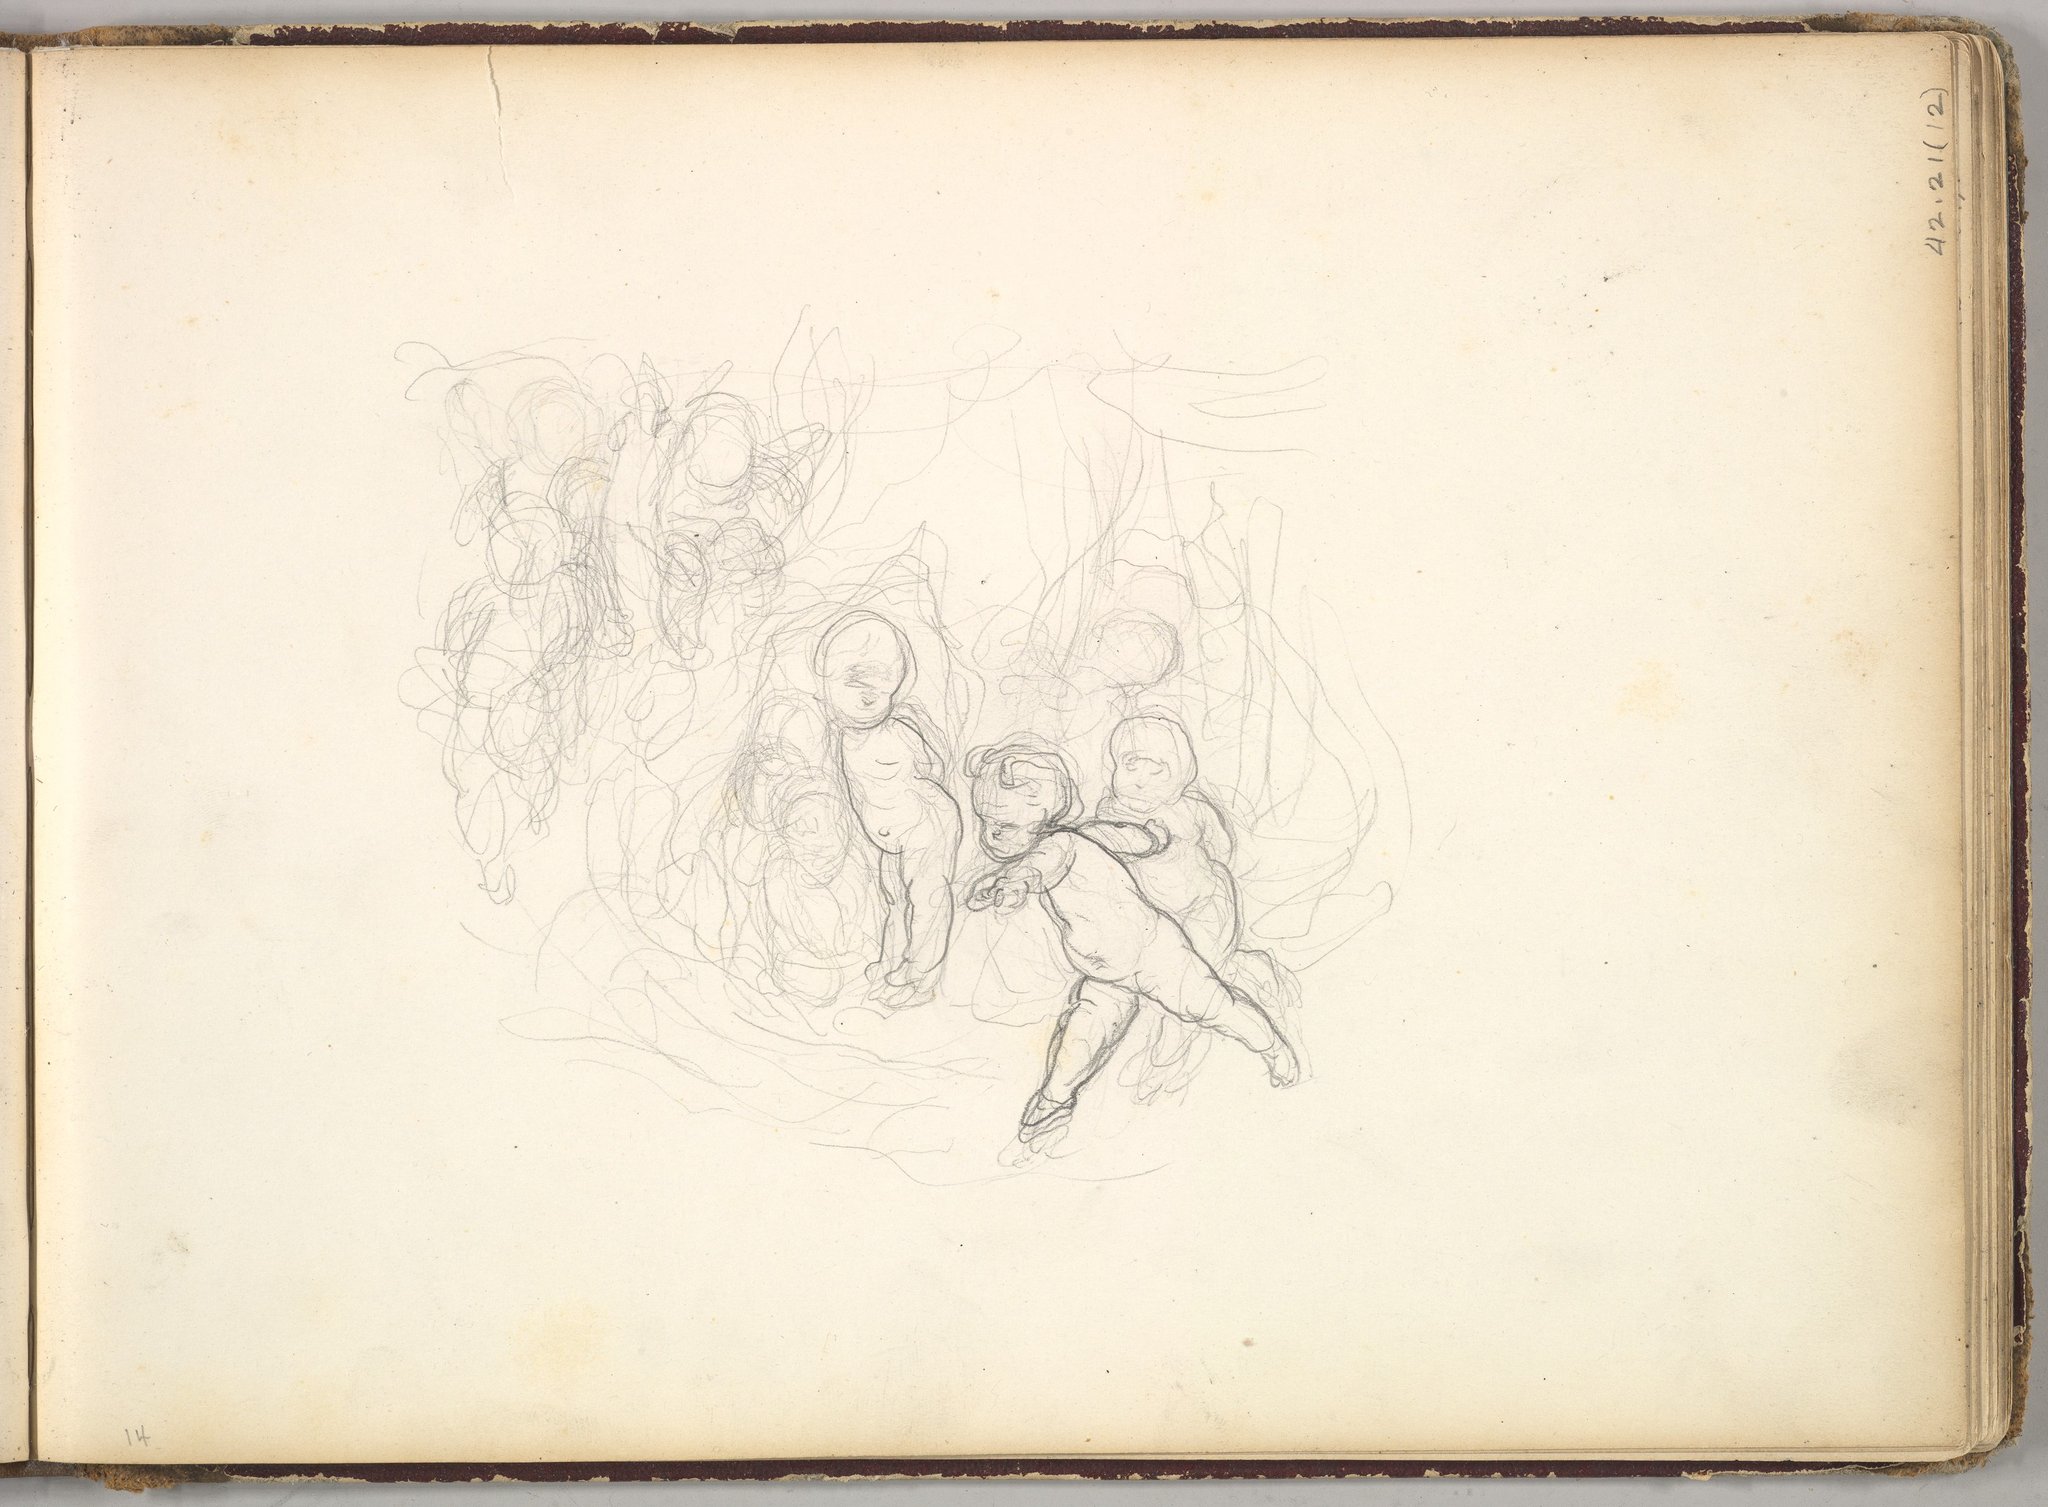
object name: drawing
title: A Group of Children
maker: frederic, lord leighton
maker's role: artist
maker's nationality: british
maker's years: 1830-1896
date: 1849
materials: graphite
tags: children